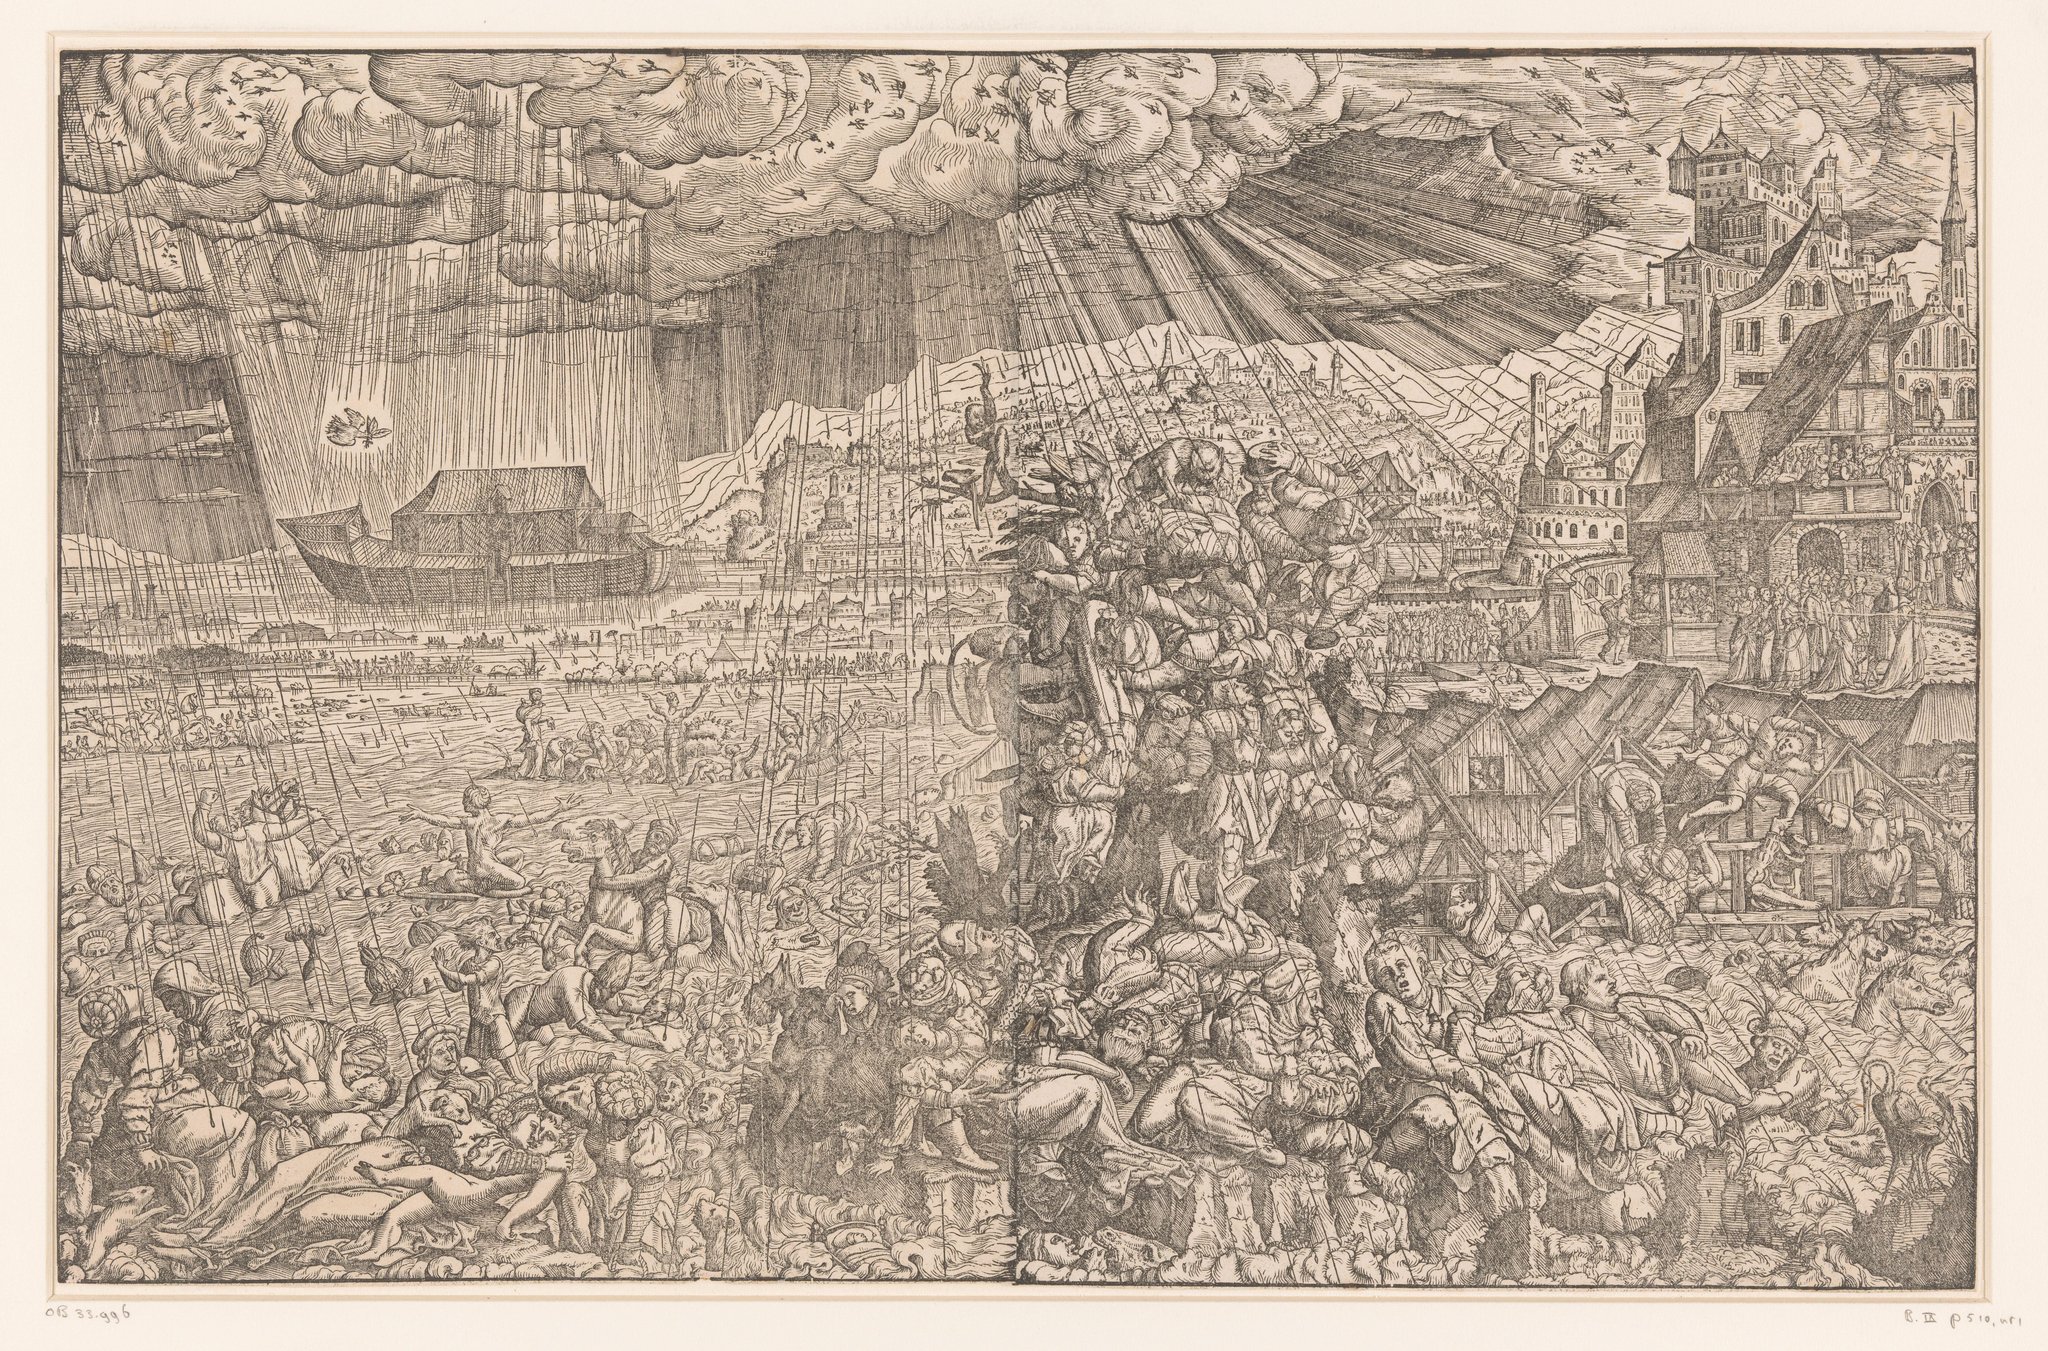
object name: print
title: De Zondvloed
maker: melchior lorck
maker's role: draughtsman, painter, print maker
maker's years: 1526-1588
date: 1551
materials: paper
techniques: woodcut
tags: the flood and destruction of mankind ~ story of noah (genesis 7:10 - 8:17)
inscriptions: collector's mark: Lugt 2228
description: De Zondvloed, met links de ark van Noach en rechts een stad met mensen in de straten. Centraal op de voorgrond klauteren mensen op een rots in een poging om aan het water te ontkomen.